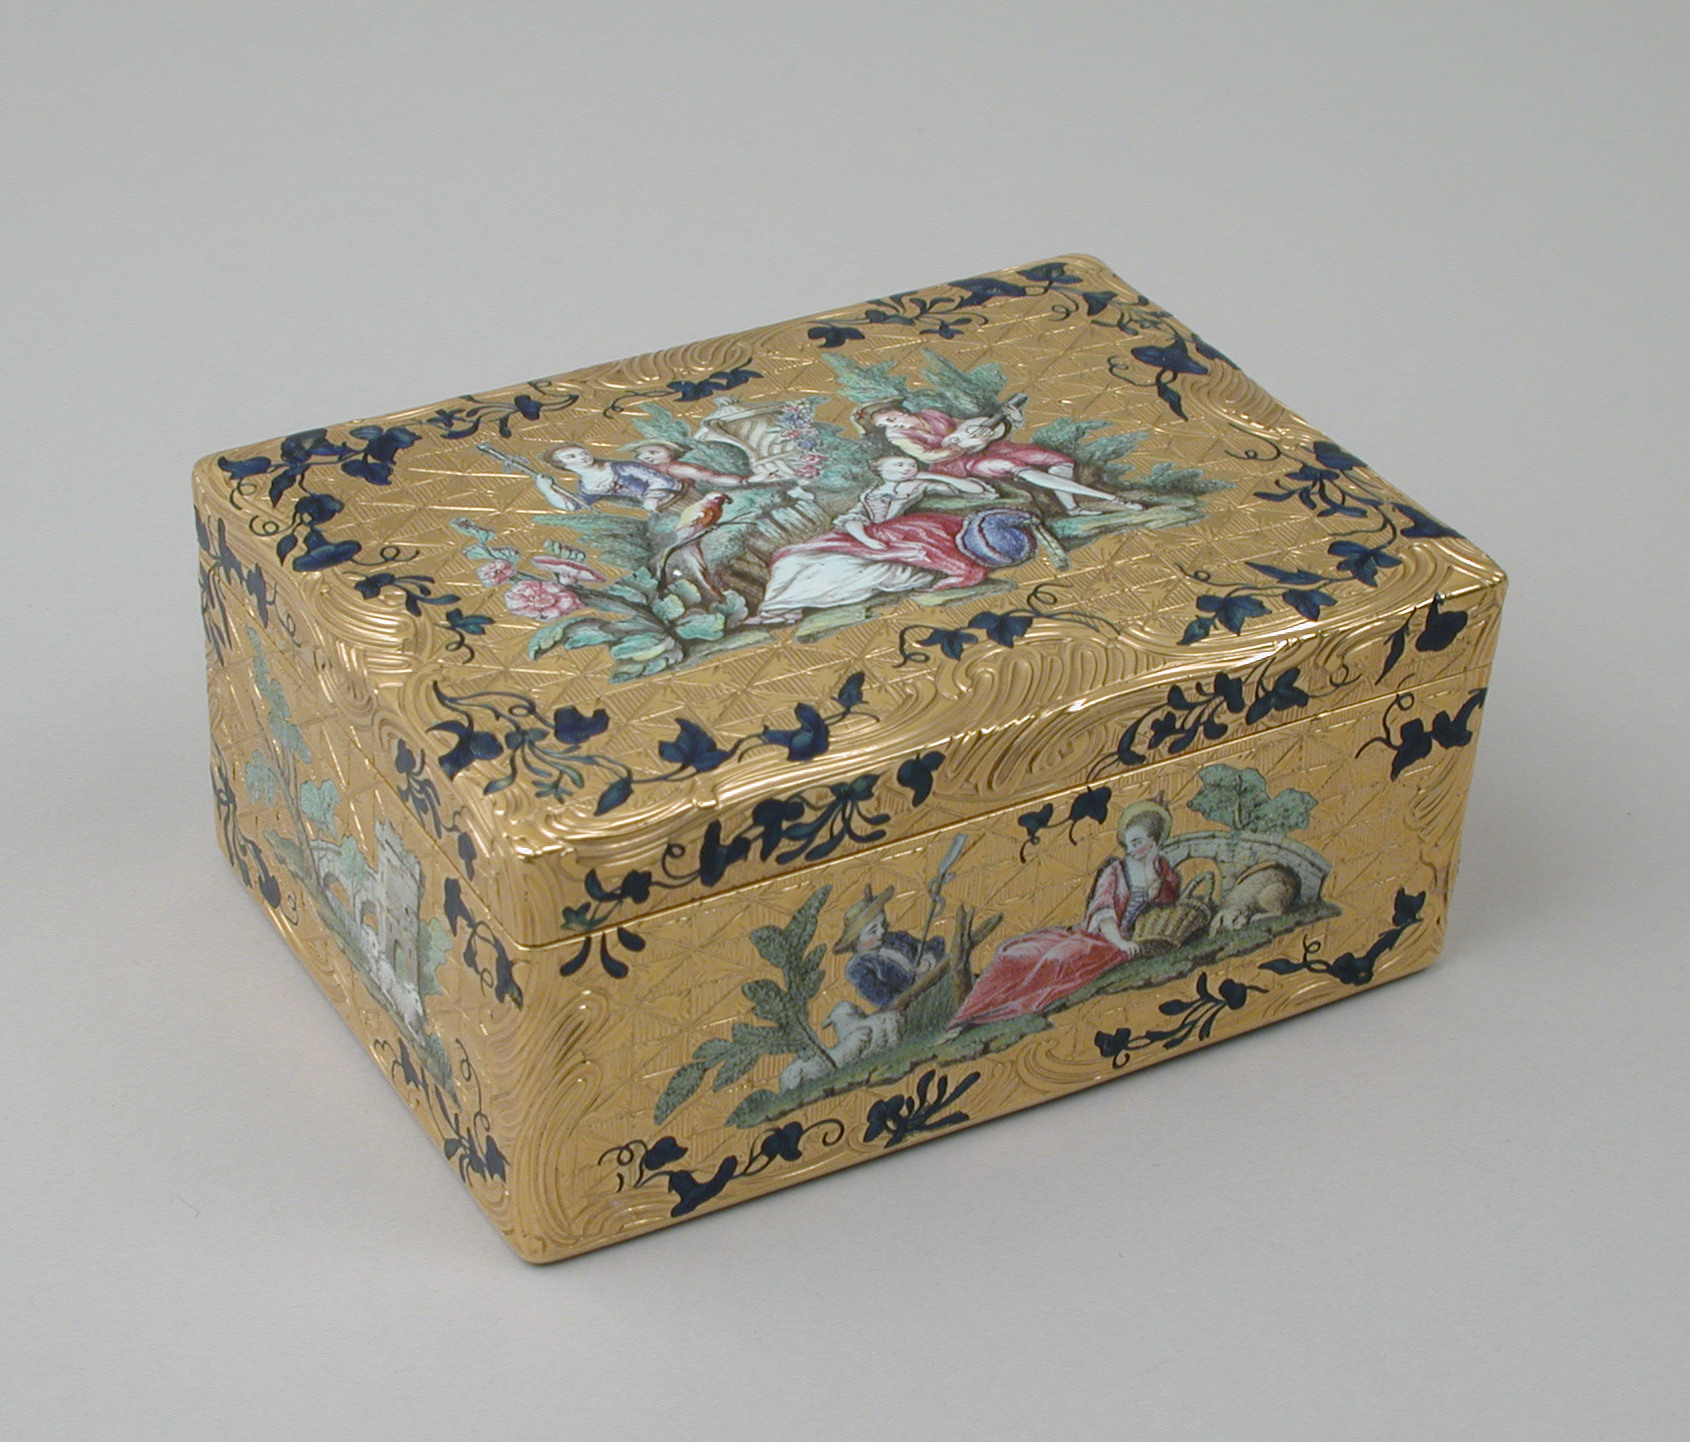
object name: snuffbox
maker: claude lisonnet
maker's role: maker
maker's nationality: french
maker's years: 1661-1761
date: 1750-1751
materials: enamel, gold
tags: human figures,musical instruments,animals,birds